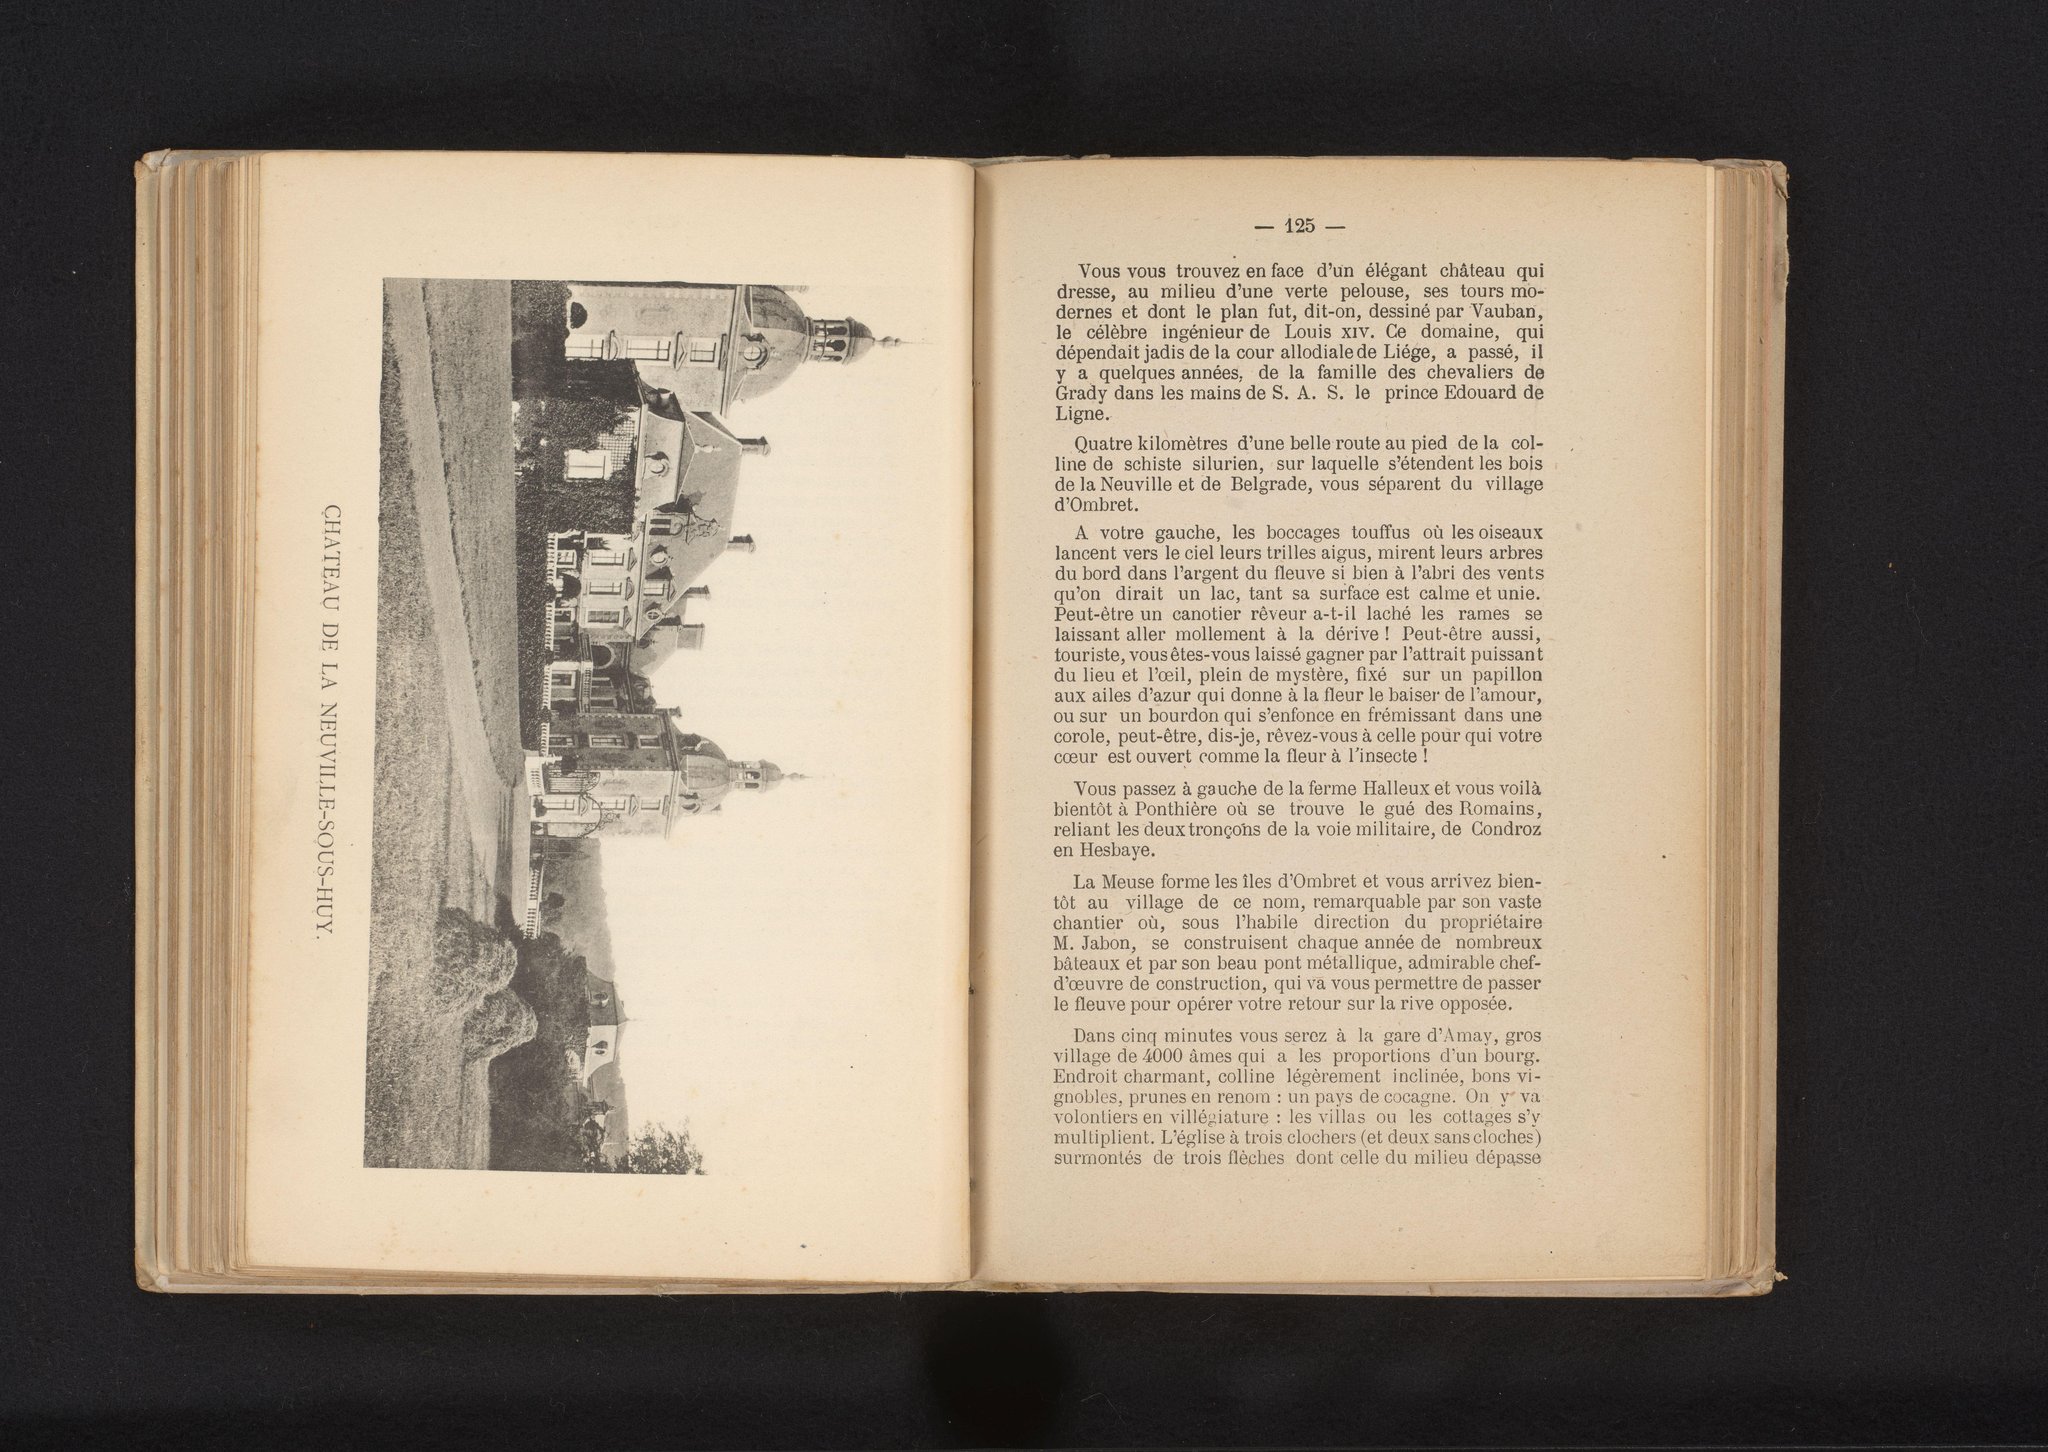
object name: page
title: Gezicht op Château de la Neuville te Neuville-sous-Huy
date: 1885-1890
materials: paper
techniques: photograph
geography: neuville-sous-huy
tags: castle